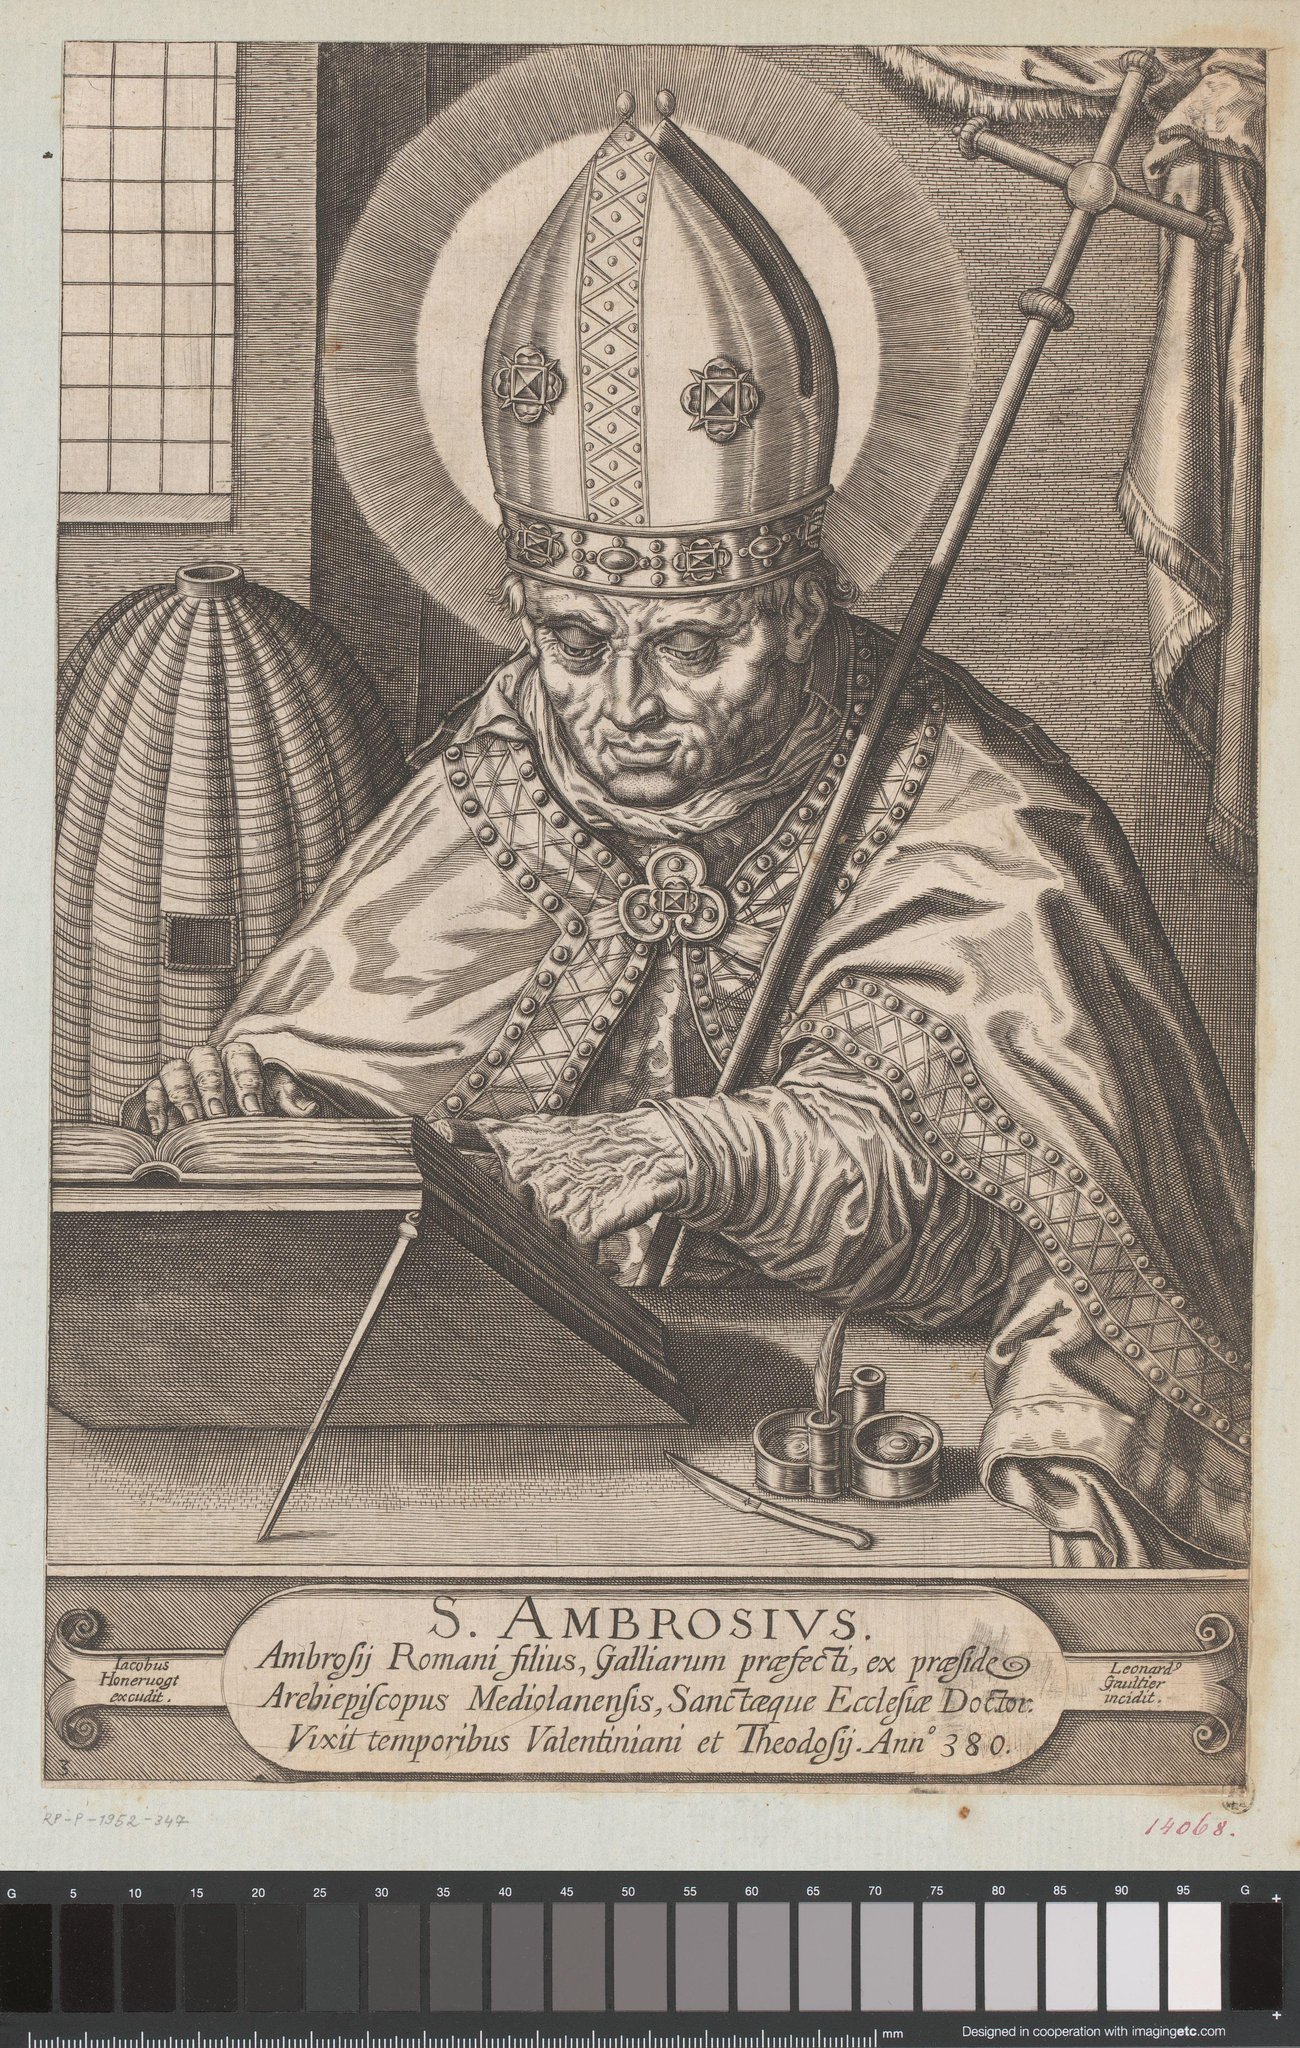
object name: print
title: Vier kerkleraren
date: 1571-1641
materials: paper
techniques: engraving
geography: paris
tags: ambrose, bishop of milan; possible attributes: beehive, cradle with baby, three-knotted scourge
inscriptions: collector's mark: ‘K [?]’